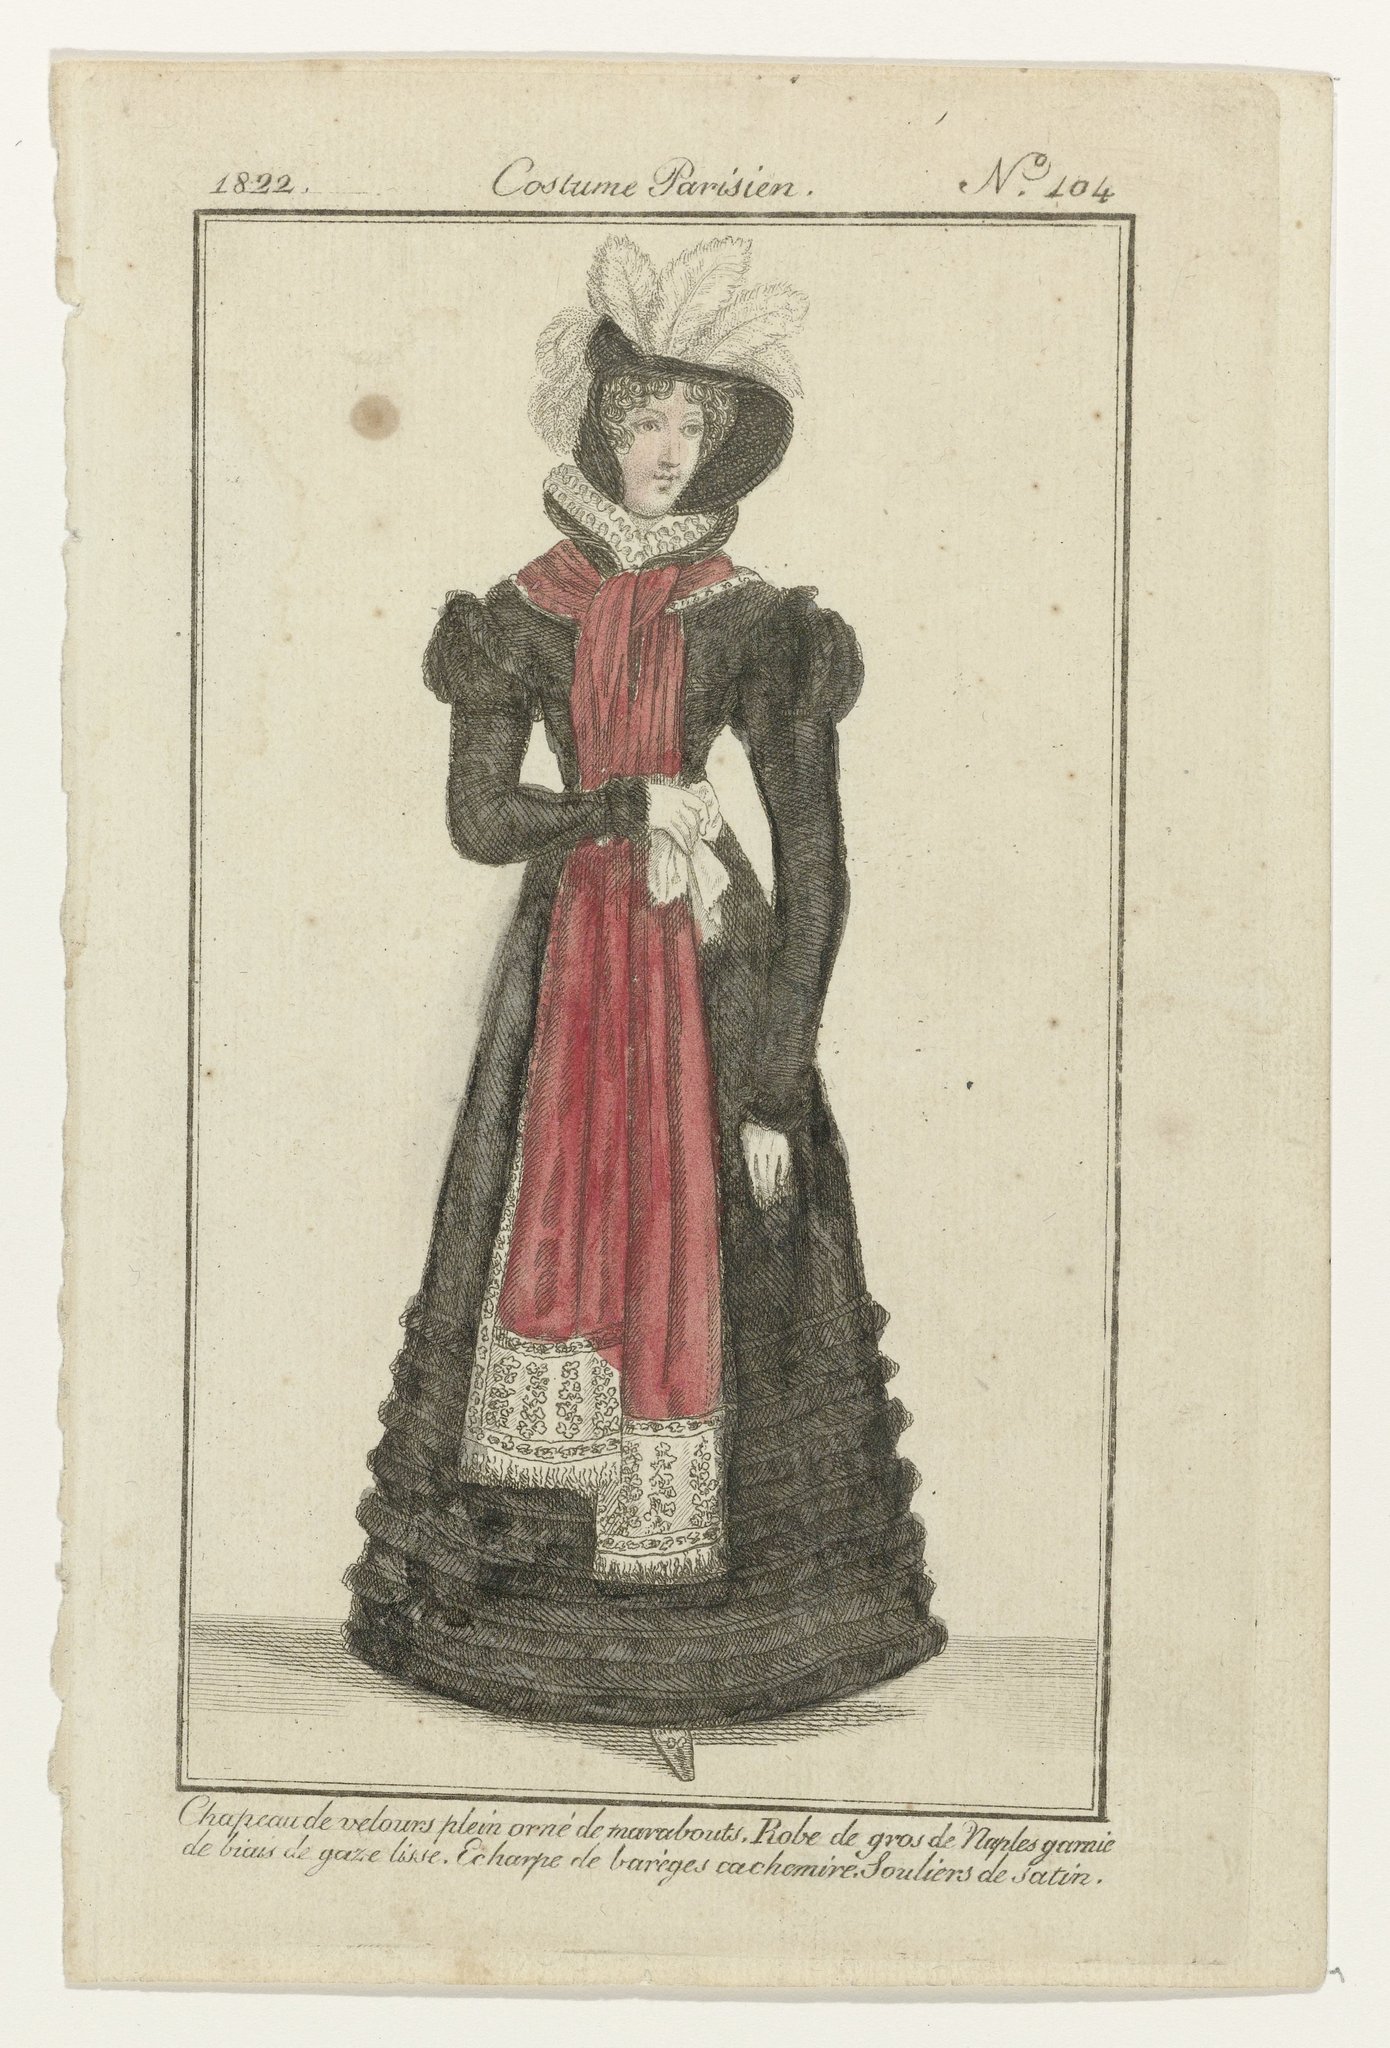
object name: fashion print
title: Journal des Dames et des Modes, Costume Parisien, kopie, 1822, No. 104 : Chapeau de velours plein (...)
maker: Anonymous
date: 1822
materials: paper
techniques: engraving, hand coloring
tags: handkerchief (+ women's clothes), clothing for the upper part of the body (shawl) (+ women's clothes), fashion plates, head-gear: hat (+ women's clothes), shoes, sandals (+ women's clothes), dress, gown (+ women's clothes), head-gear: hat (+ feathers used for clothes)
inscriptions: title: ‘Costume Parisien.’, caption: ‘Chapeau de velours plein orné de marabouts. Robe de gros de Naples garnie de biais de gaze lisse. Echarpe de baréges cachemire. Souliers de satin.’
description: Staande vrouw gekleed in een japon van 'gros de Naples' versierd met biaisband van 'gaze lisse'. Op het hoofd een luifelhoed van effen fluweel versierd met maraboeveren. Verdere accessoires: sjaal van 'barèges-cachemire', zakdoek, schoenen van satijn. Kopie naar een prent uit het modetijdschrift Journal des Dames et des Modes, uitgegeven door Pierre de la Mésangère, Parijs, 1797-1839.